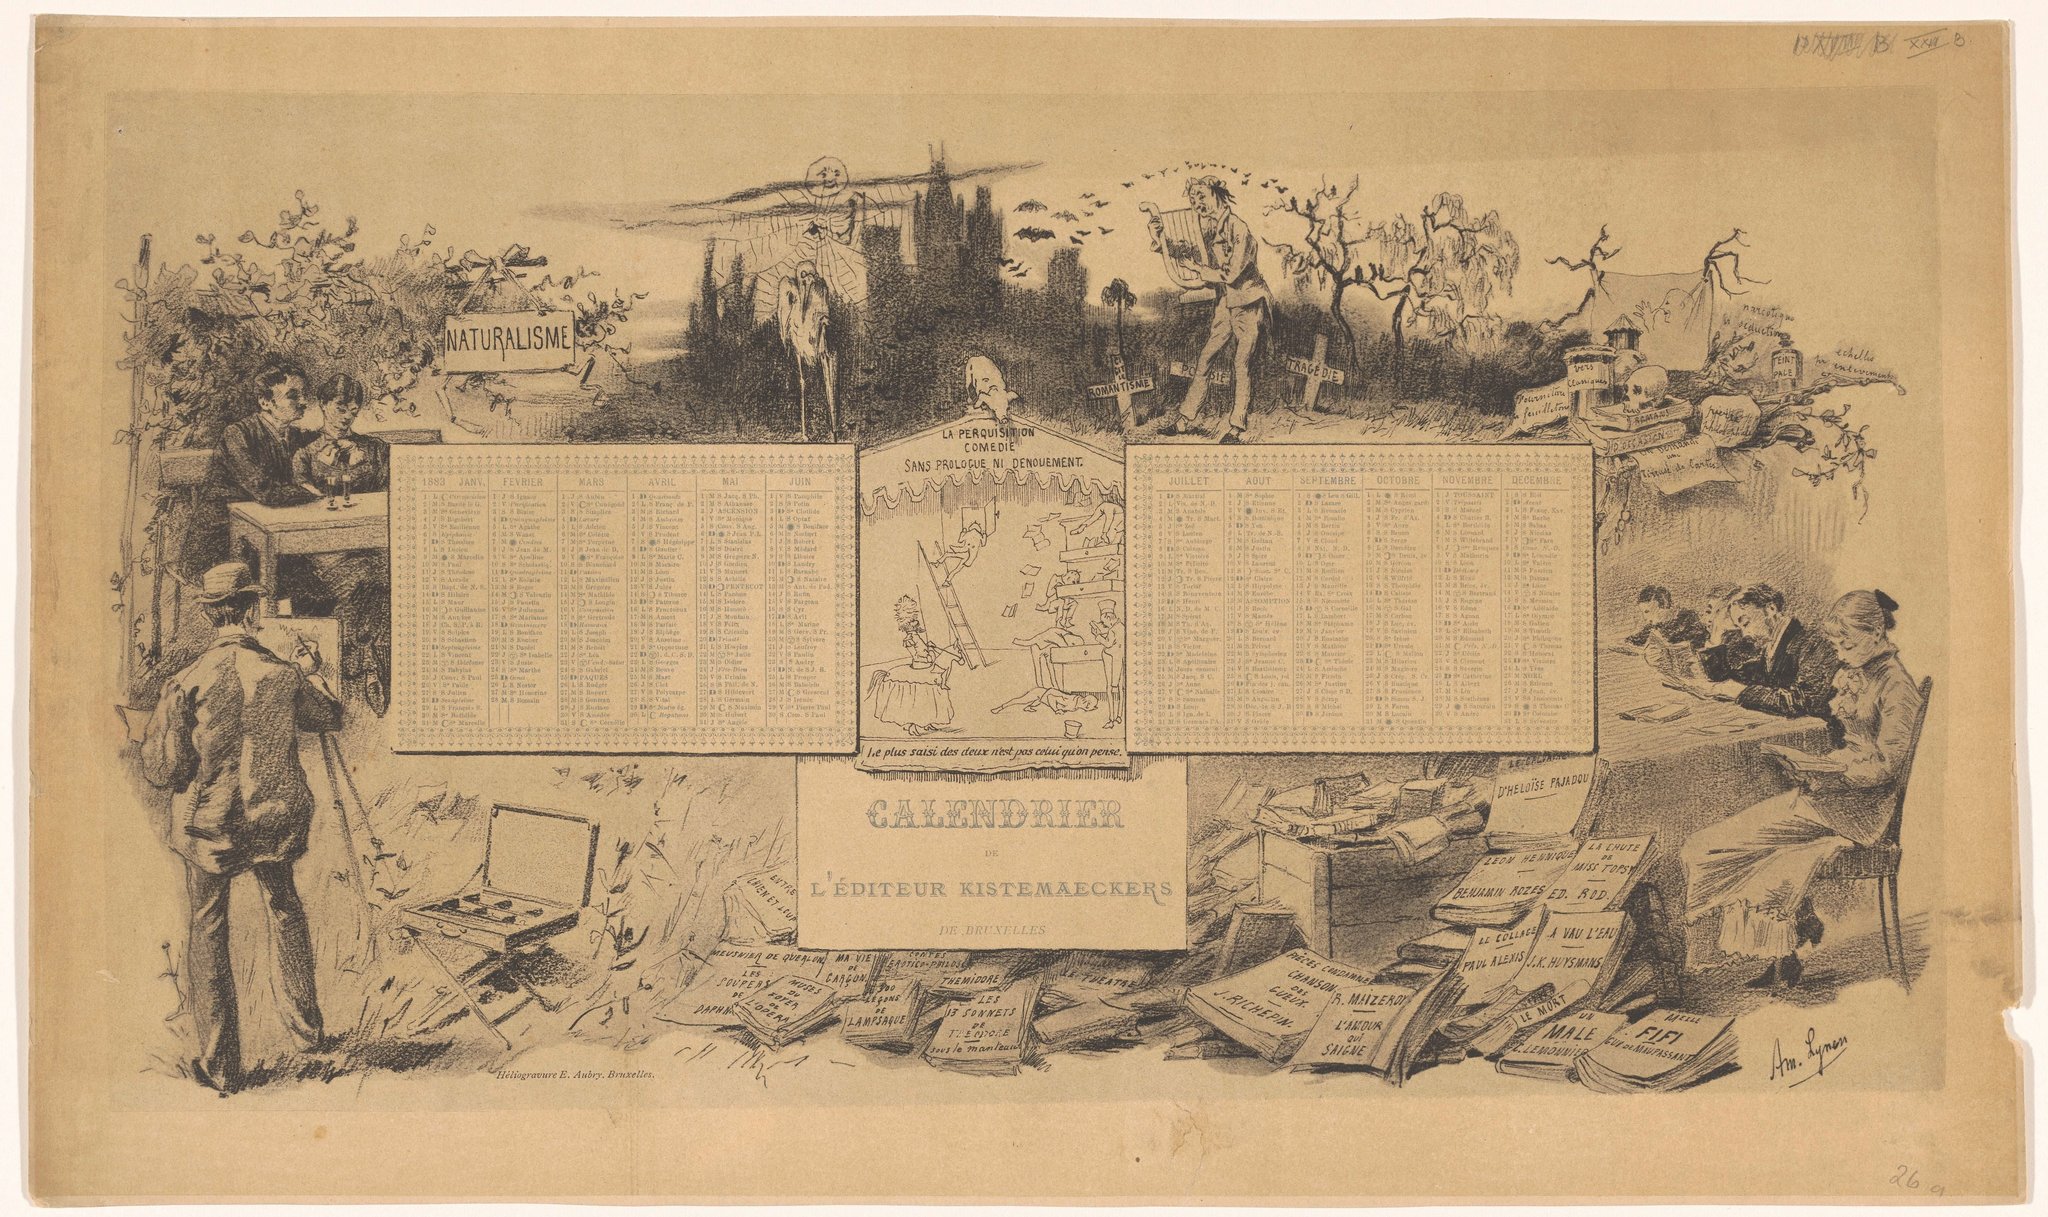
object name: print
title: Kalender van uitgeverij Kistemaeckers voor het jaar 1883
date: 1882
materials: paper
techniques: letterpress printing, photoaquatint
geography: brussels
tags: working situations ~ painter - cc - out of doors, calendar, almanac, book, churchyard, cemetery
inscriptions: collector's mark: Lugt 2228, collector's mark: Lugt 4780, collector's mark: Lugt 4779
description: In het midden de kalender met een humoristische scène. Rechts lezende mensen achter een tafel met daarvoor stapels boeken met leesbare titels. Boven de kalender speelt een man op een harp op een begraafplaats waar Romantiek, Poëzie en Tragedie begraven liggen. Links schildert een kunstenaar een man en een vrouw die op een terras zitten.